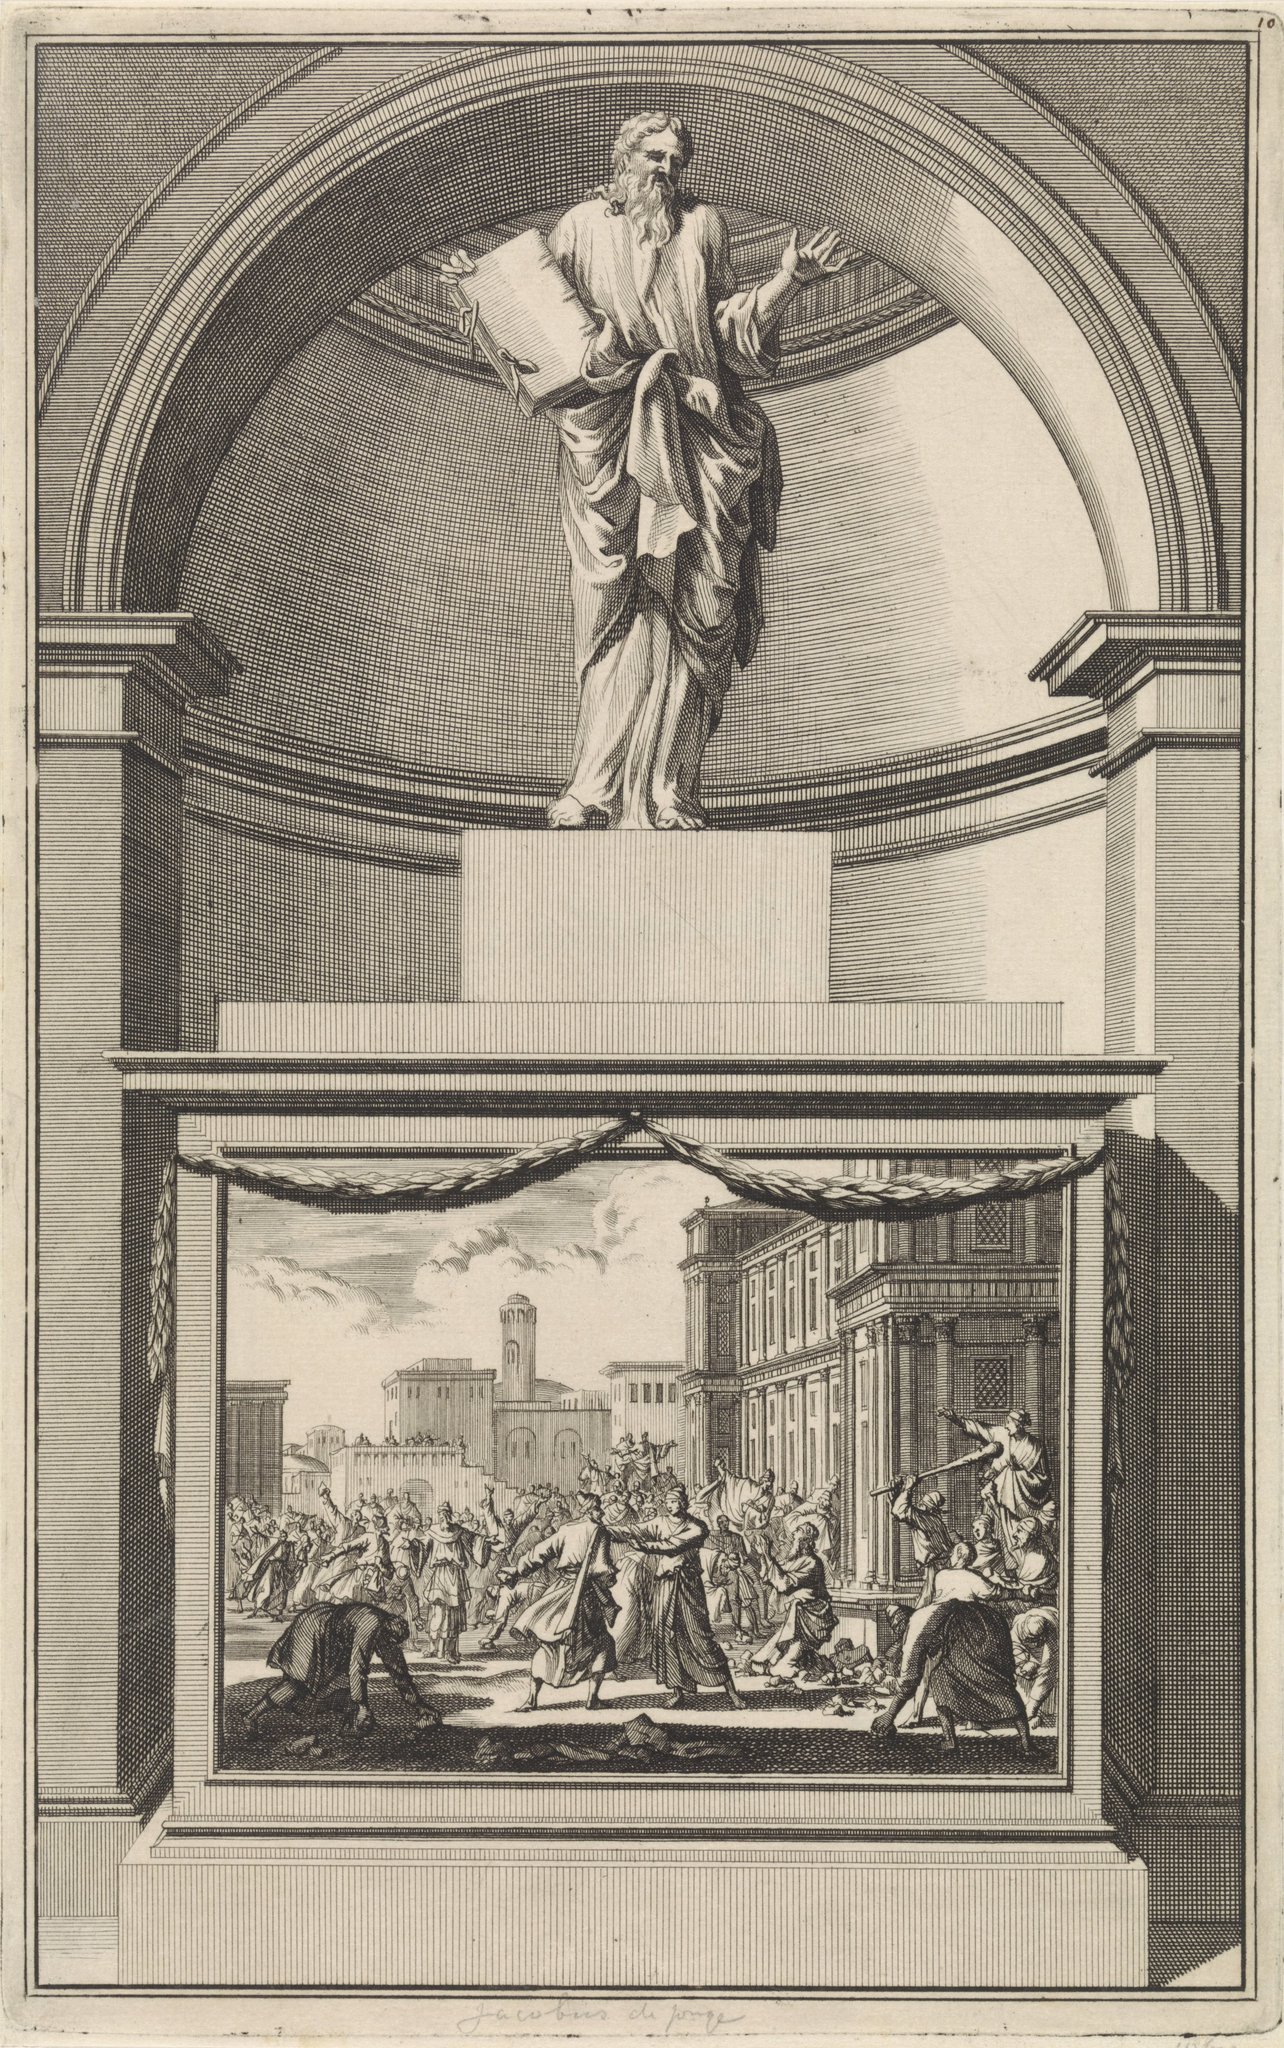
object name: print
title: Apostel Jakobus de Mindere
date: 1698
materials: paper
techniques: engraving, etching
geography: amsterdam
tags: the apostle james the less, first bishop of jerusalem; possible attributes: book, fuller's club, scroll, james is stoned, or beaten to death (with a fuller's club)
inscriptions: collector's mark: Lugt 2228, number: ‘10’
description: Proefdruk van illustratie uit: Cave, William. Apostolische oudheden, of Het leven (...) der heylige apostelen, 3 delen. Utrecht: François Halma en Willem van de Water (I), 1698, p. 329.